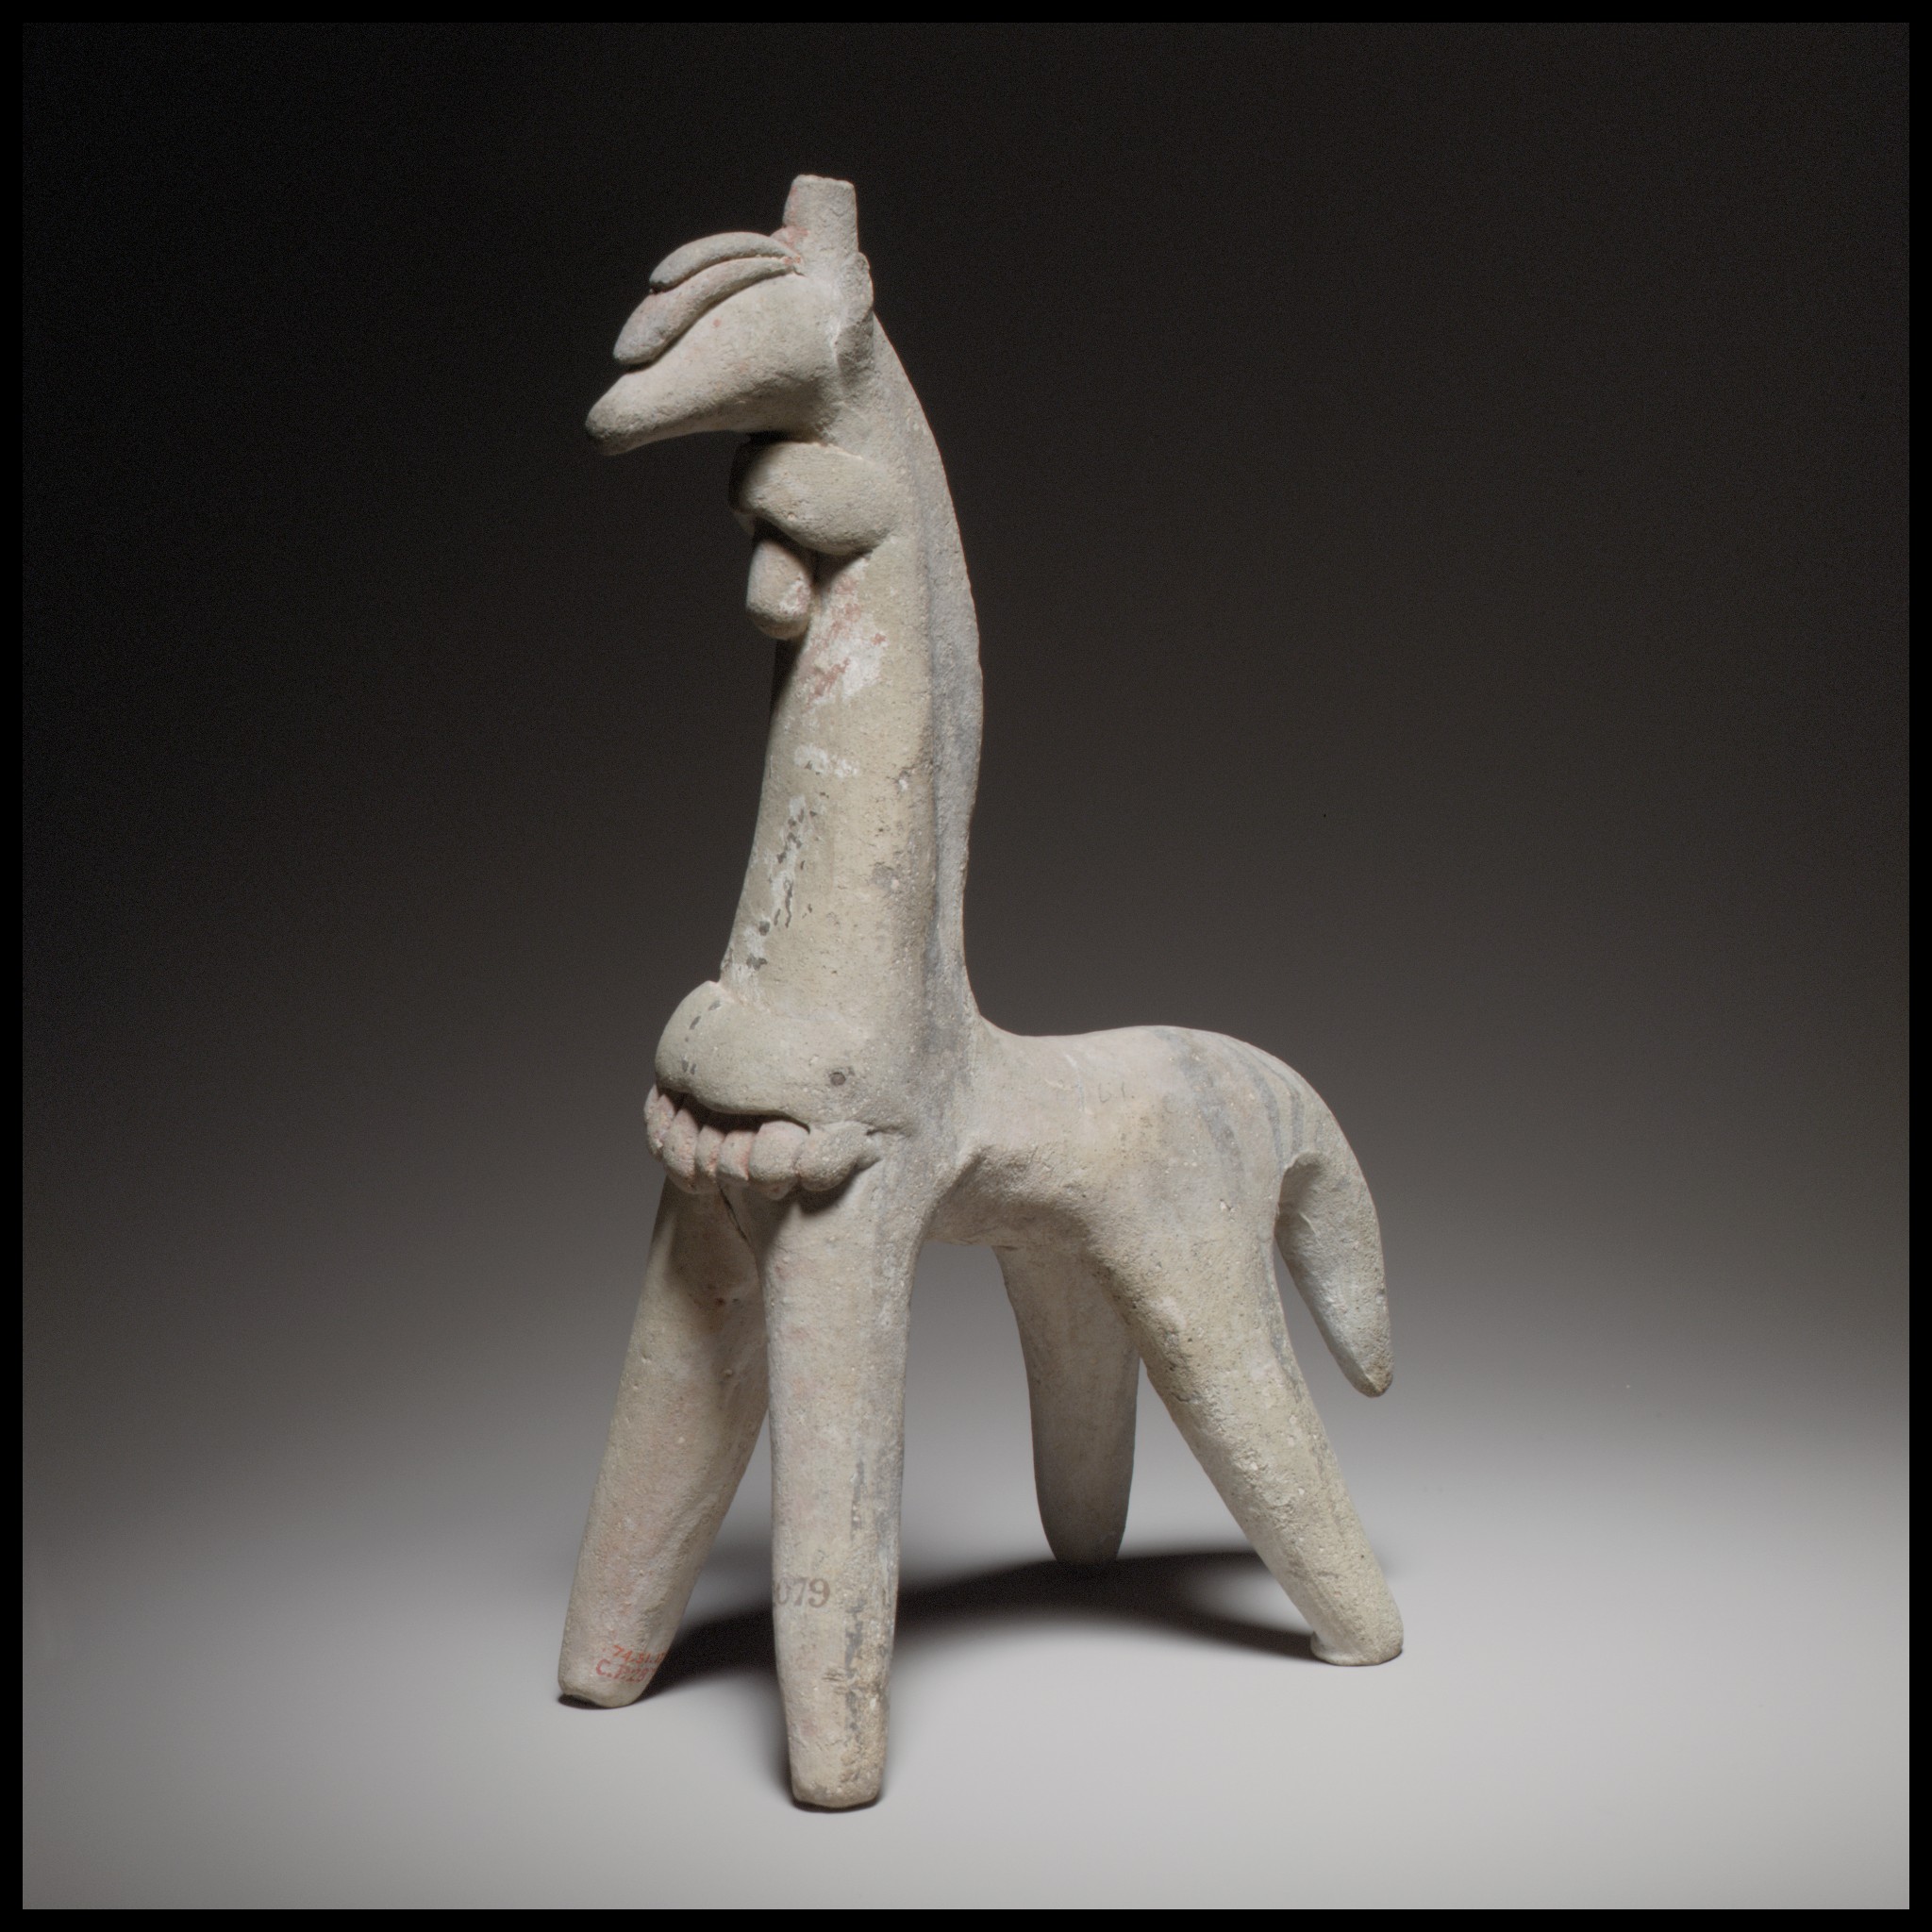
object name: statuette of a horse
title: Horse figurine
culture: cypriot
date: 600-480 BCE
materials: terracotta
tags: horses